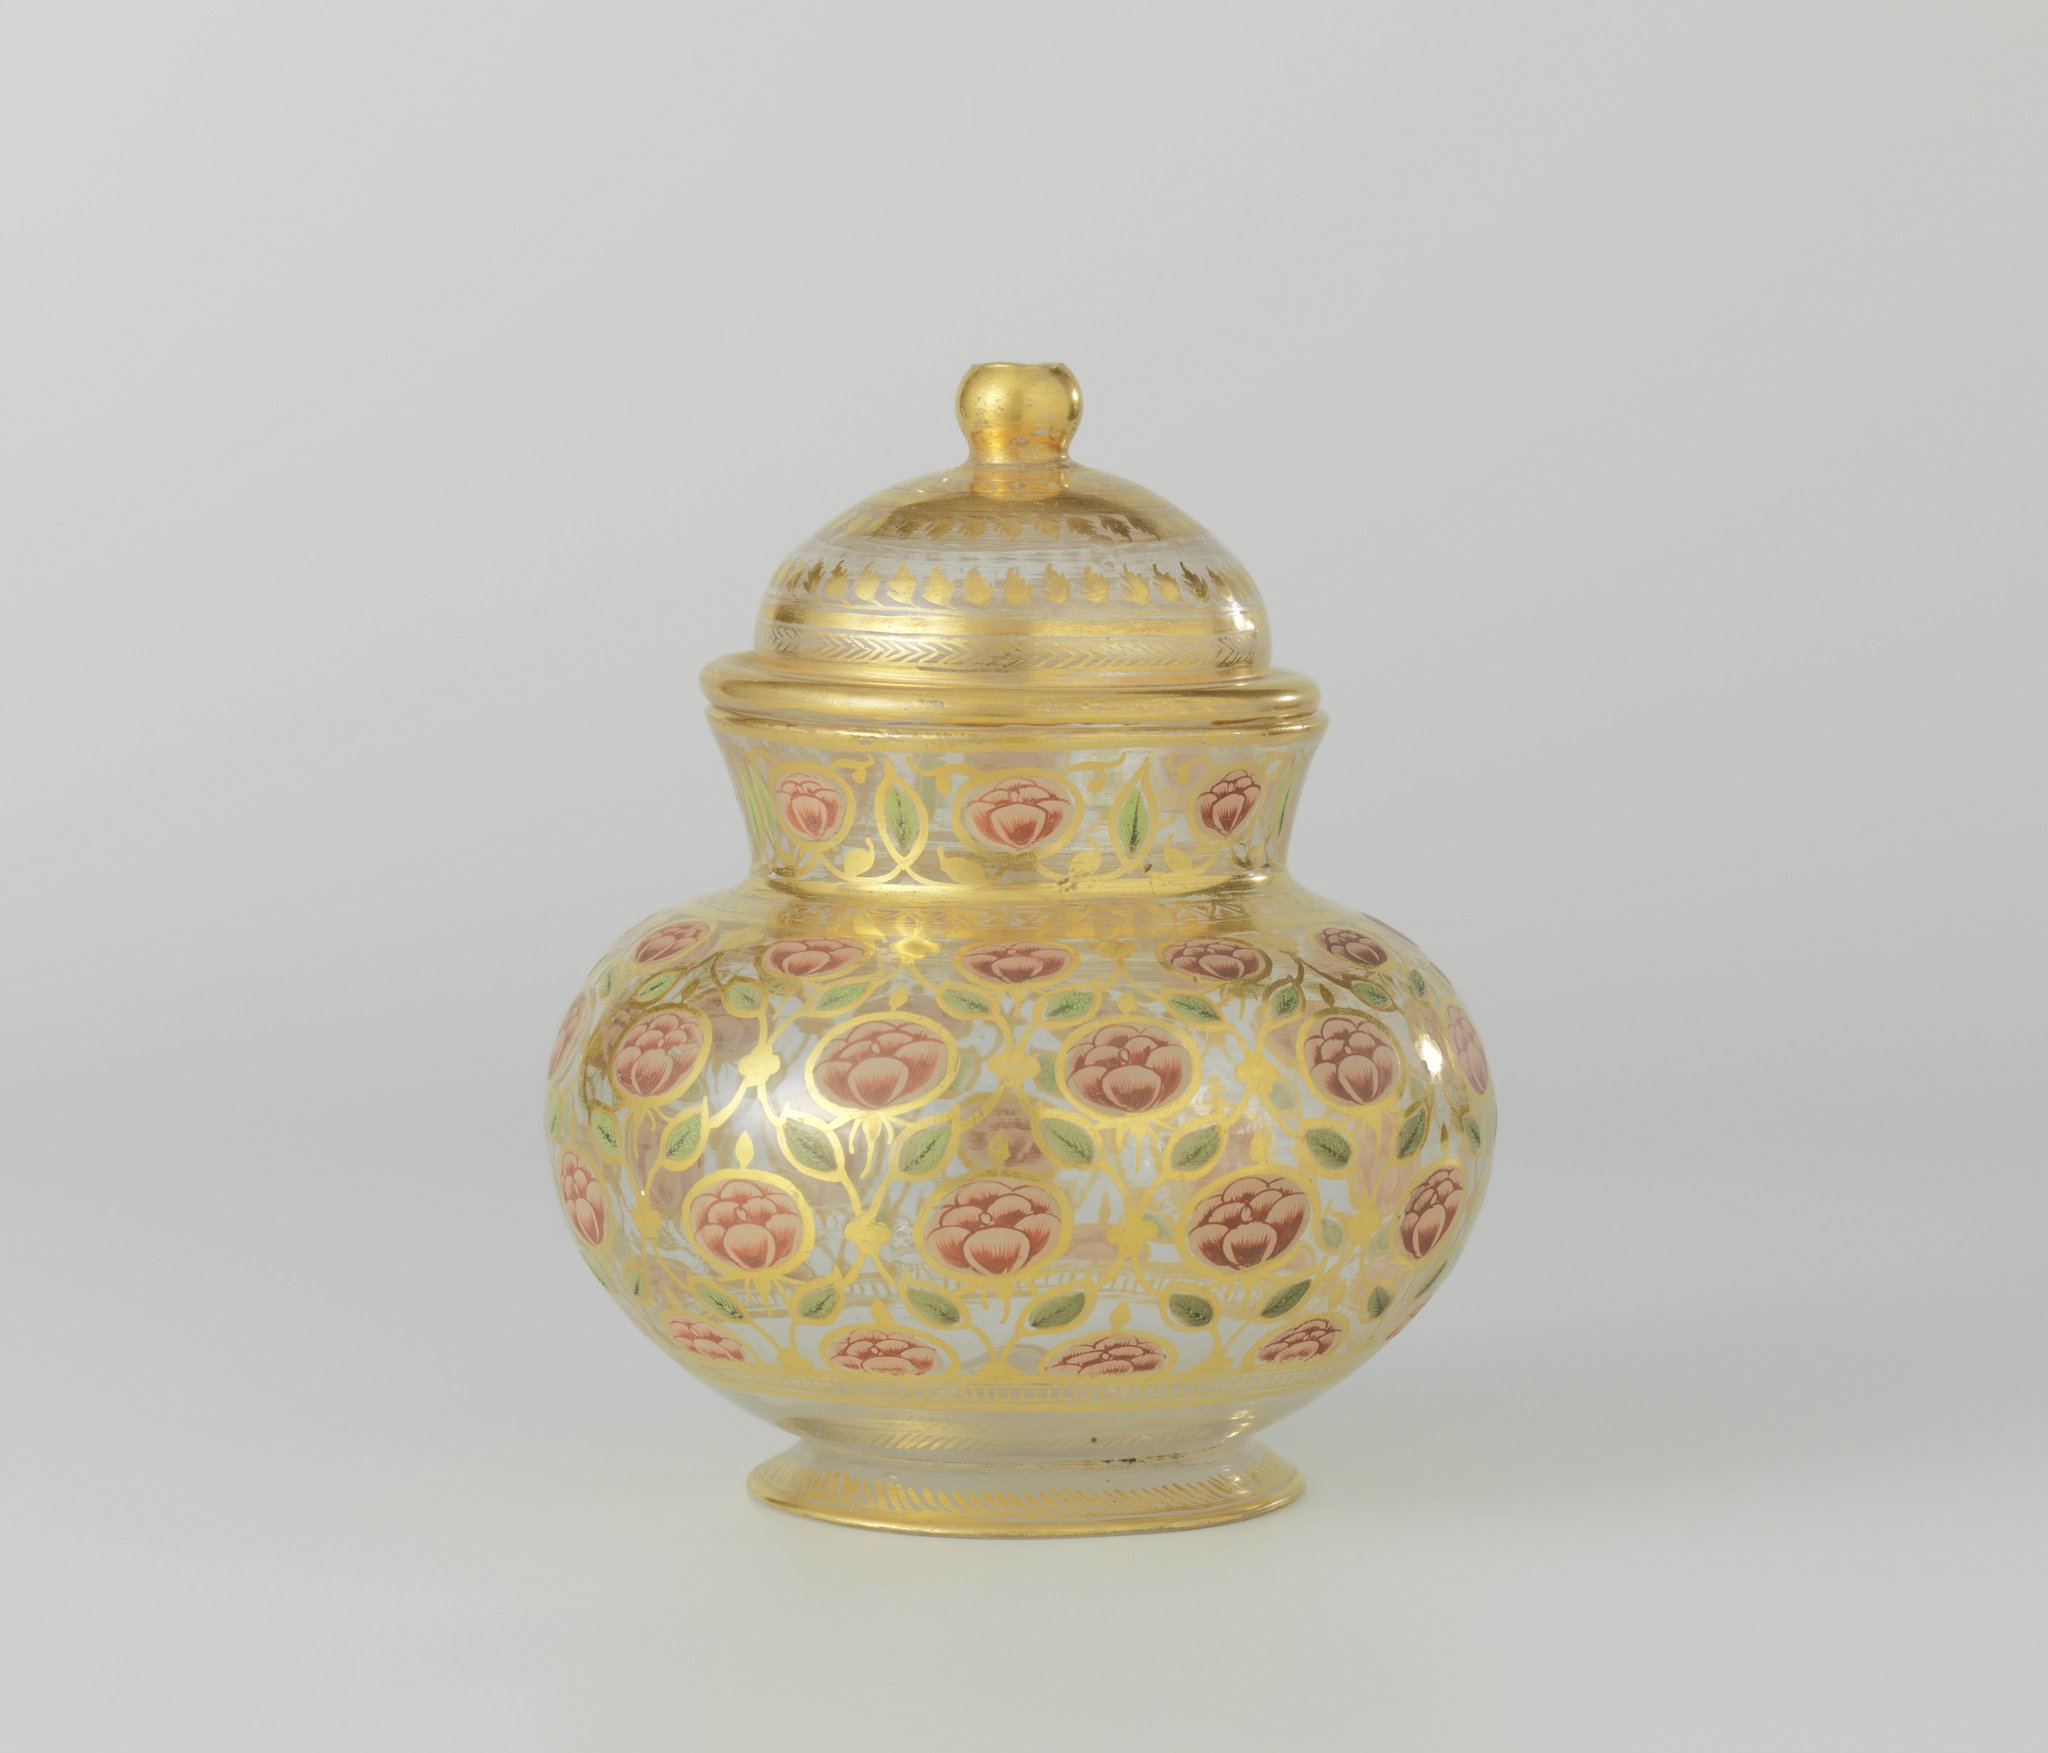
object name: covered jar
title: Dekselpot met schotel, beschilderd met bloemen in roze en goud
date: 1775-1800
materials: glass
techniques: gilding, glassblowing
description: Ronde pot op een spreidende voet en meteen hoge, licht spreidende hals; een onderschotel en een bolle deksel met ronde dekselknop. Beschilderd met bloemtakken in roze en goud en met banden met geometrische patronen.